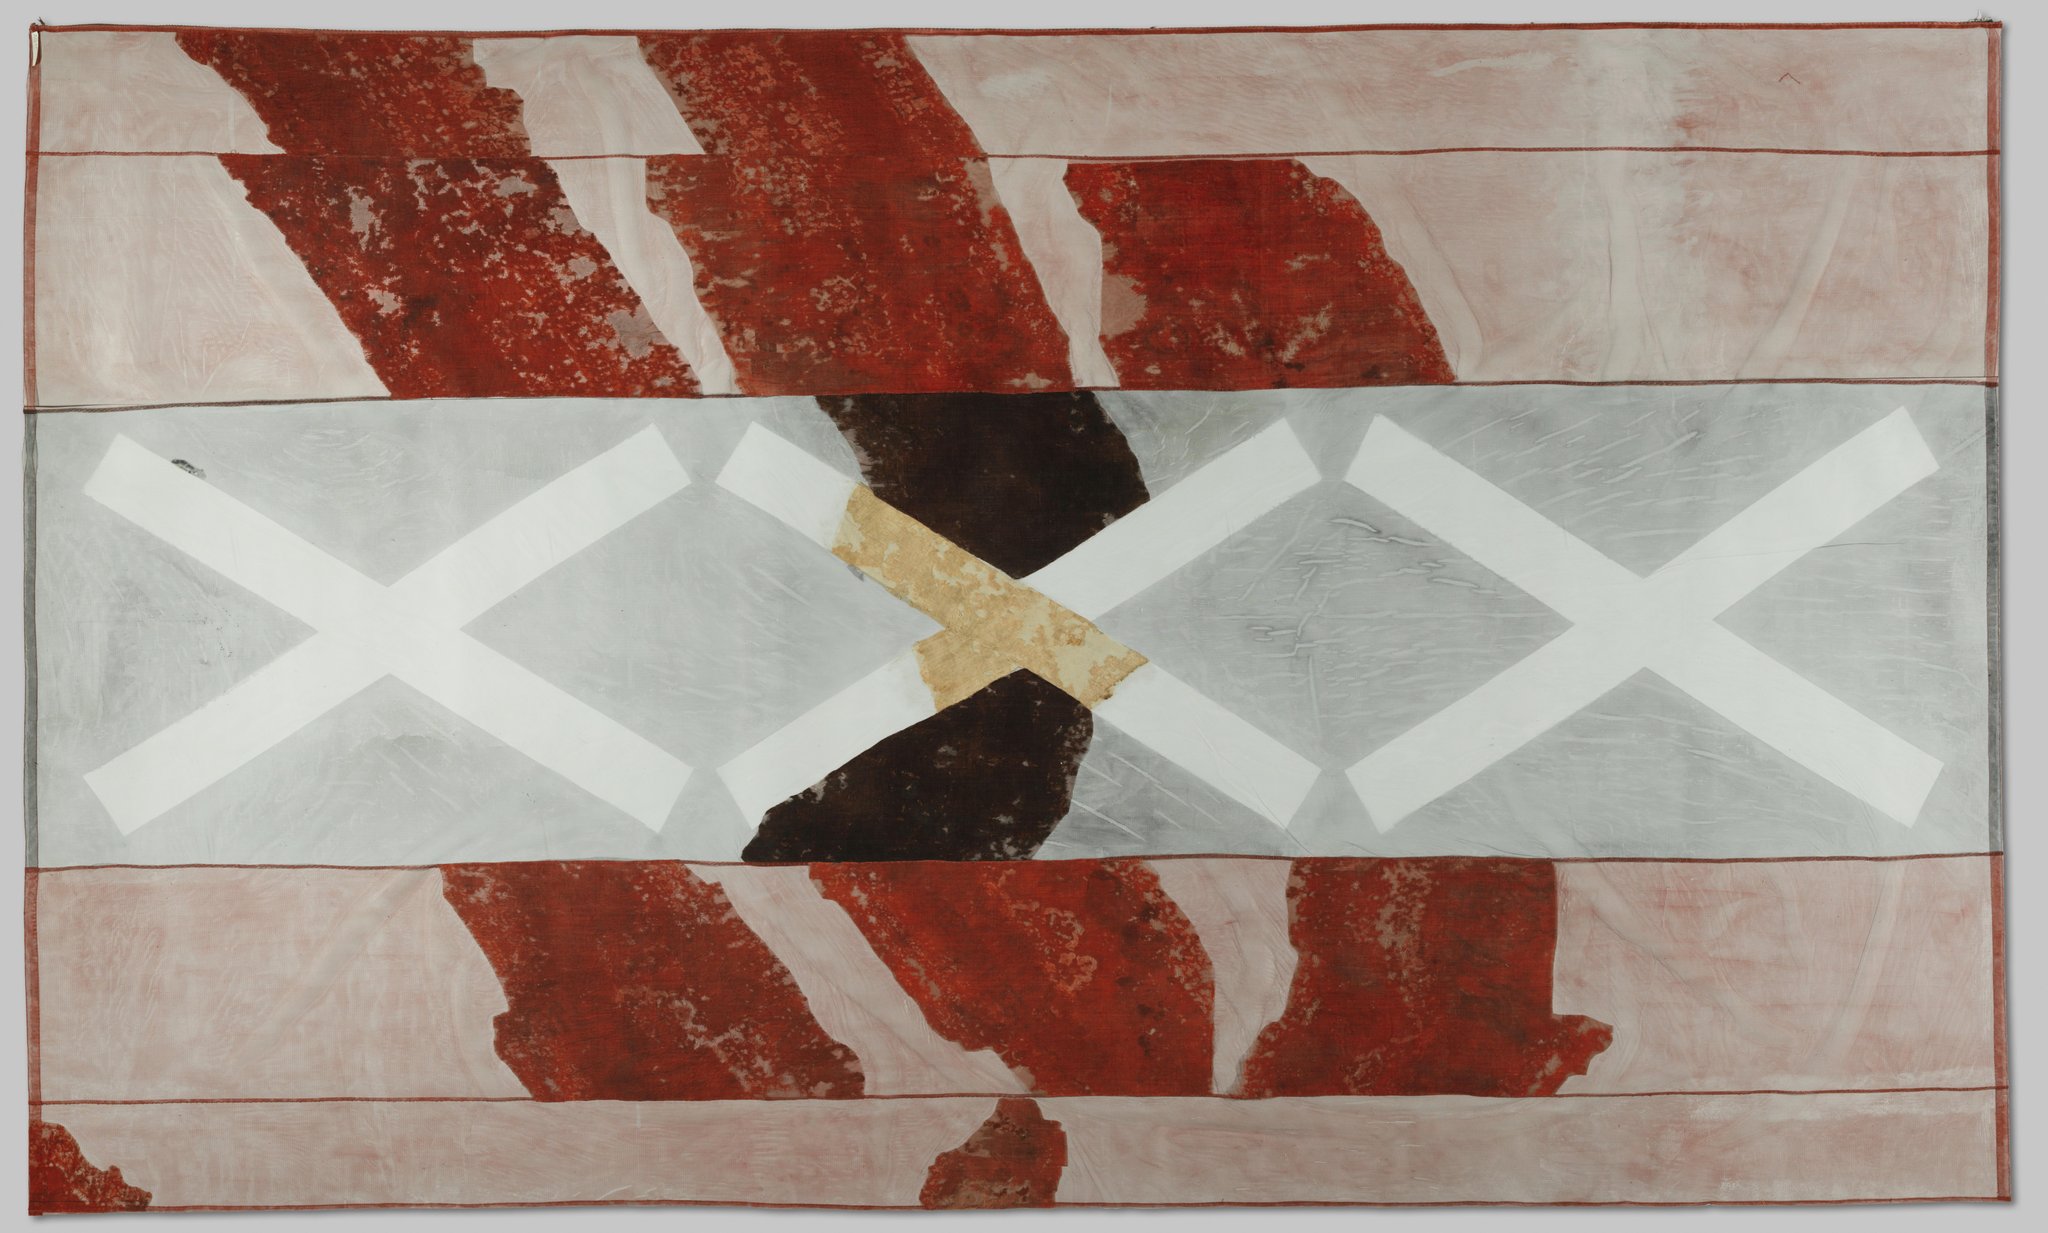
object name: ship flag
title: Fragment van een scheepsvlag met drie banen in de kleuren rood, zwart en rood en drie witte Andreaskruisen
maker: Anonymous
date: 1596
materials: wool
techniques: weave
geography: amsterdam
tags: willem barendsz., amsterdam, jacob van heemskerck, coat of arms (as symbol of the state, etc.) (+ city; municipal)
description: Scheepsvlag, oorspronkelijk rechthoekig van vorm. De vlag heeft drie banen in de kleuren rood, zwart en rood. Op de zwarte middenbaan zijn drie witte Andreaskruisen aangebracht, het wapen van Amsterdam. Sinds 1978 is de vlag samengevoegd en gereconstrueerd met de zes delen afkomstig uit het Tromsomuseum. Gezien de afmetingen heeft de vlag waarschijnlijk op de achtersteven of top van de bezaansmast gewapperd.